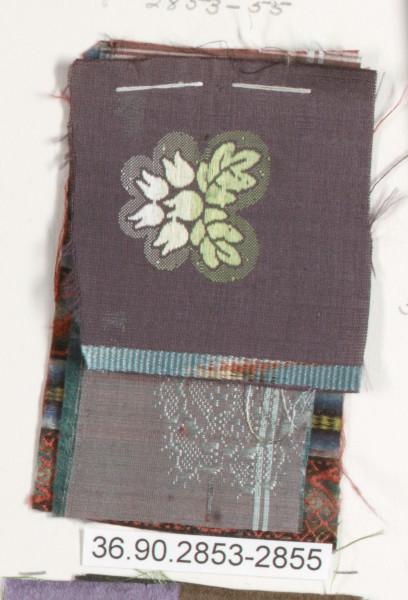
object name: piece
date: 1801-1900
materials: silk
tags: flowers,leaves